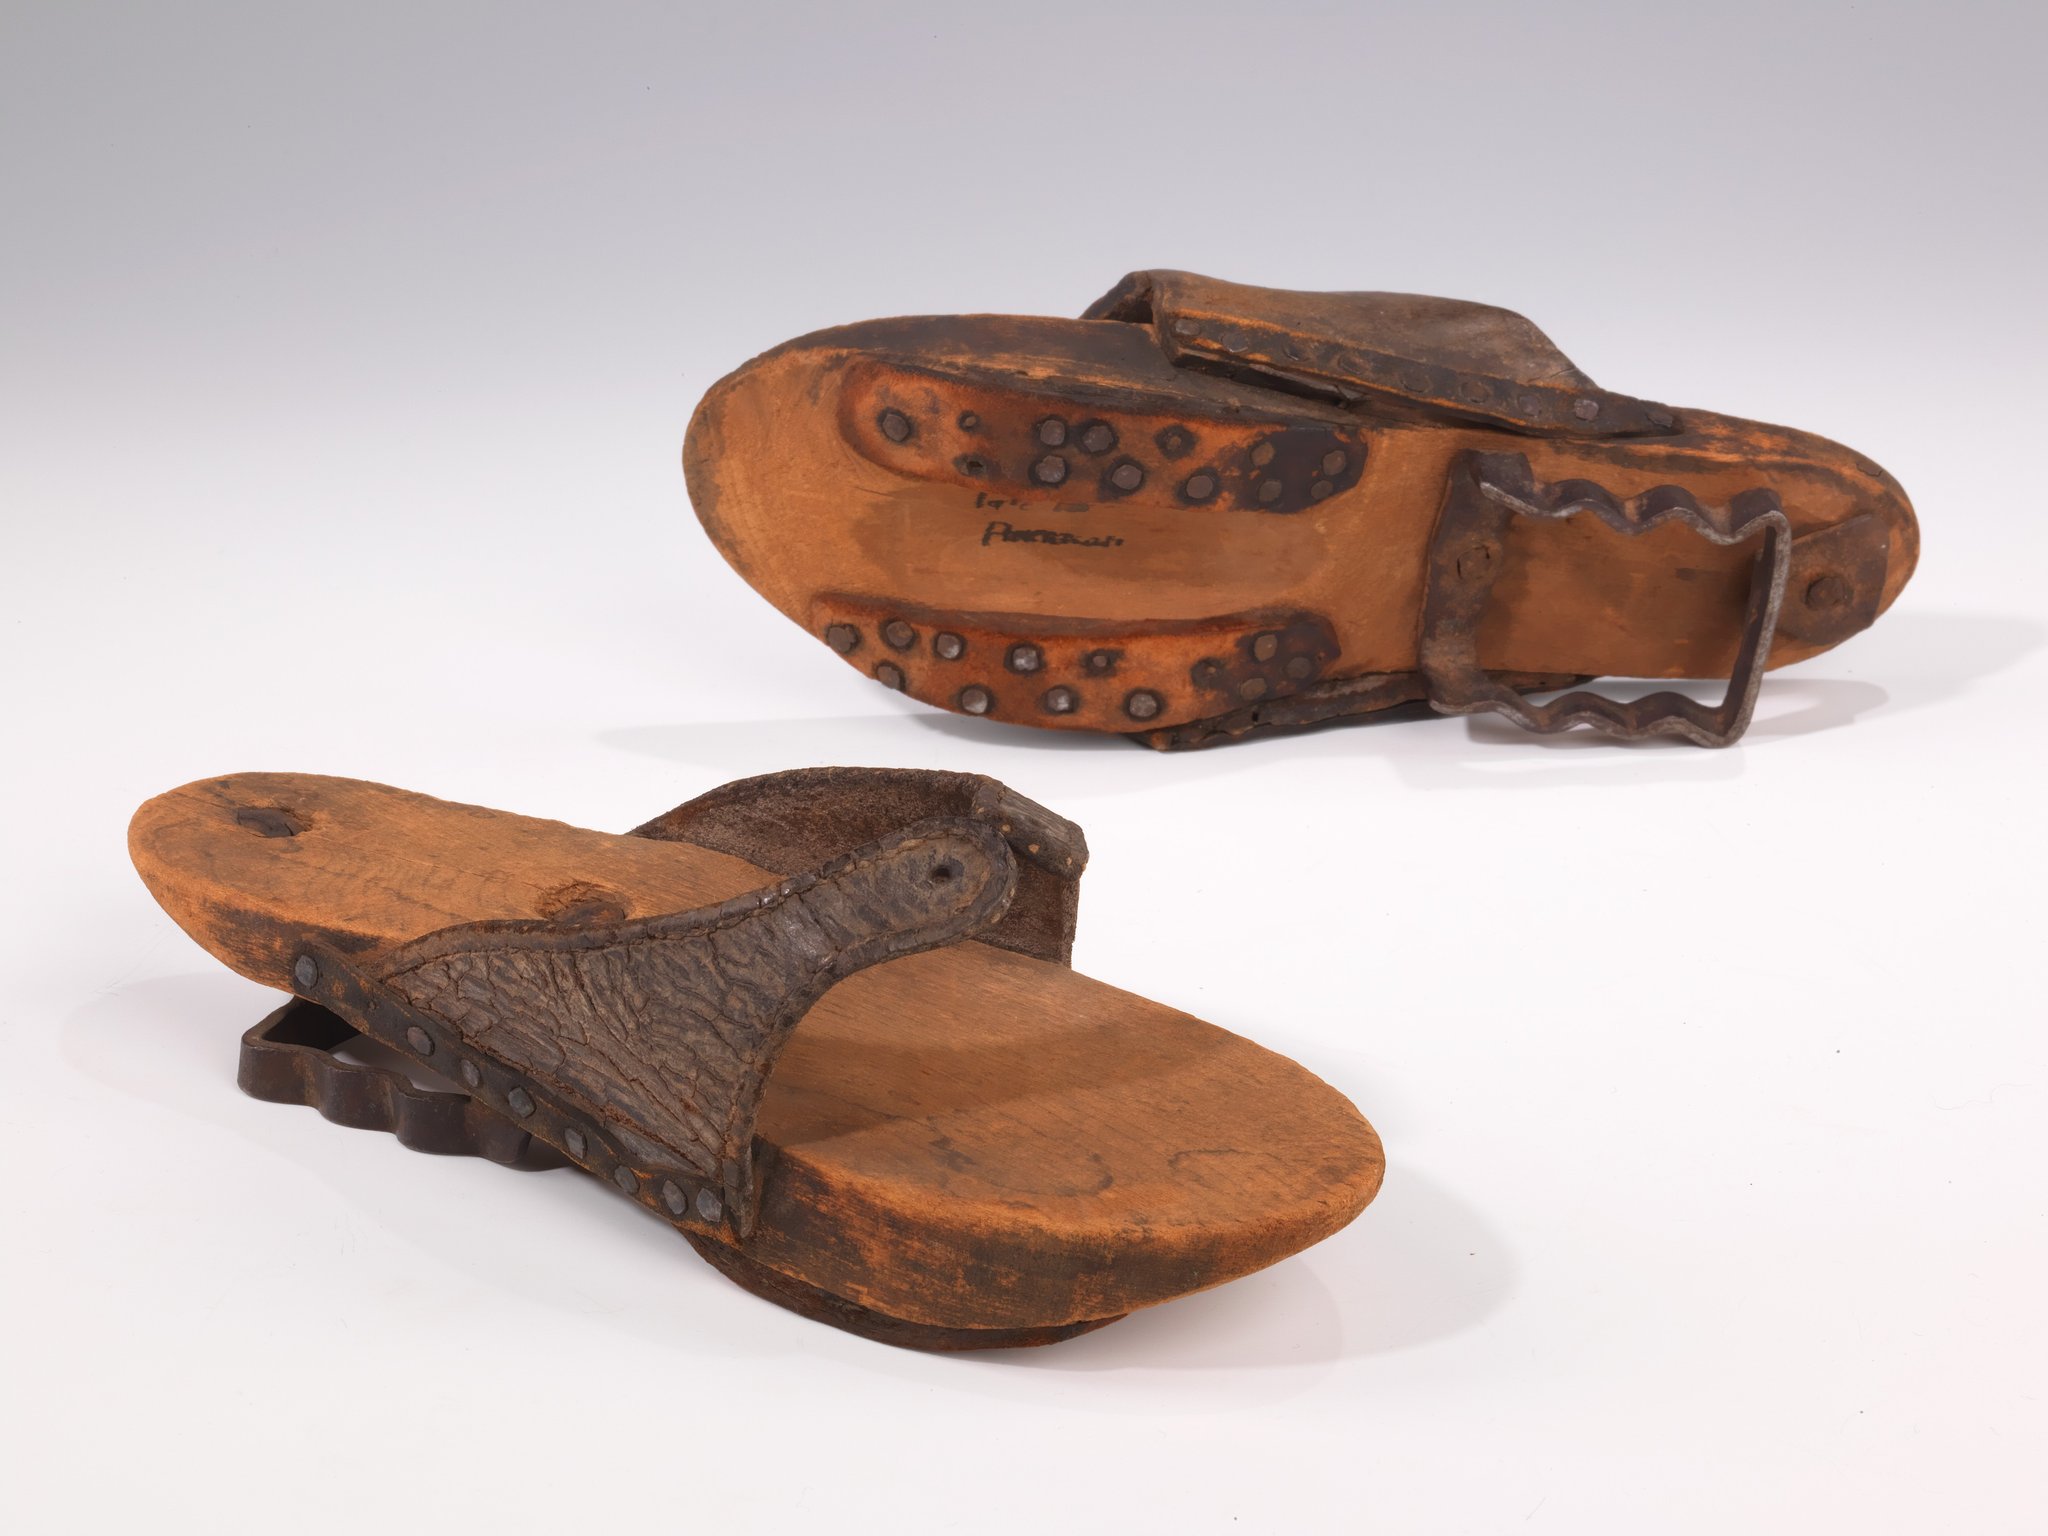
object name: patten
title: Pattens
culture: american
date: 1767-1800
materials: leather, metal, wood